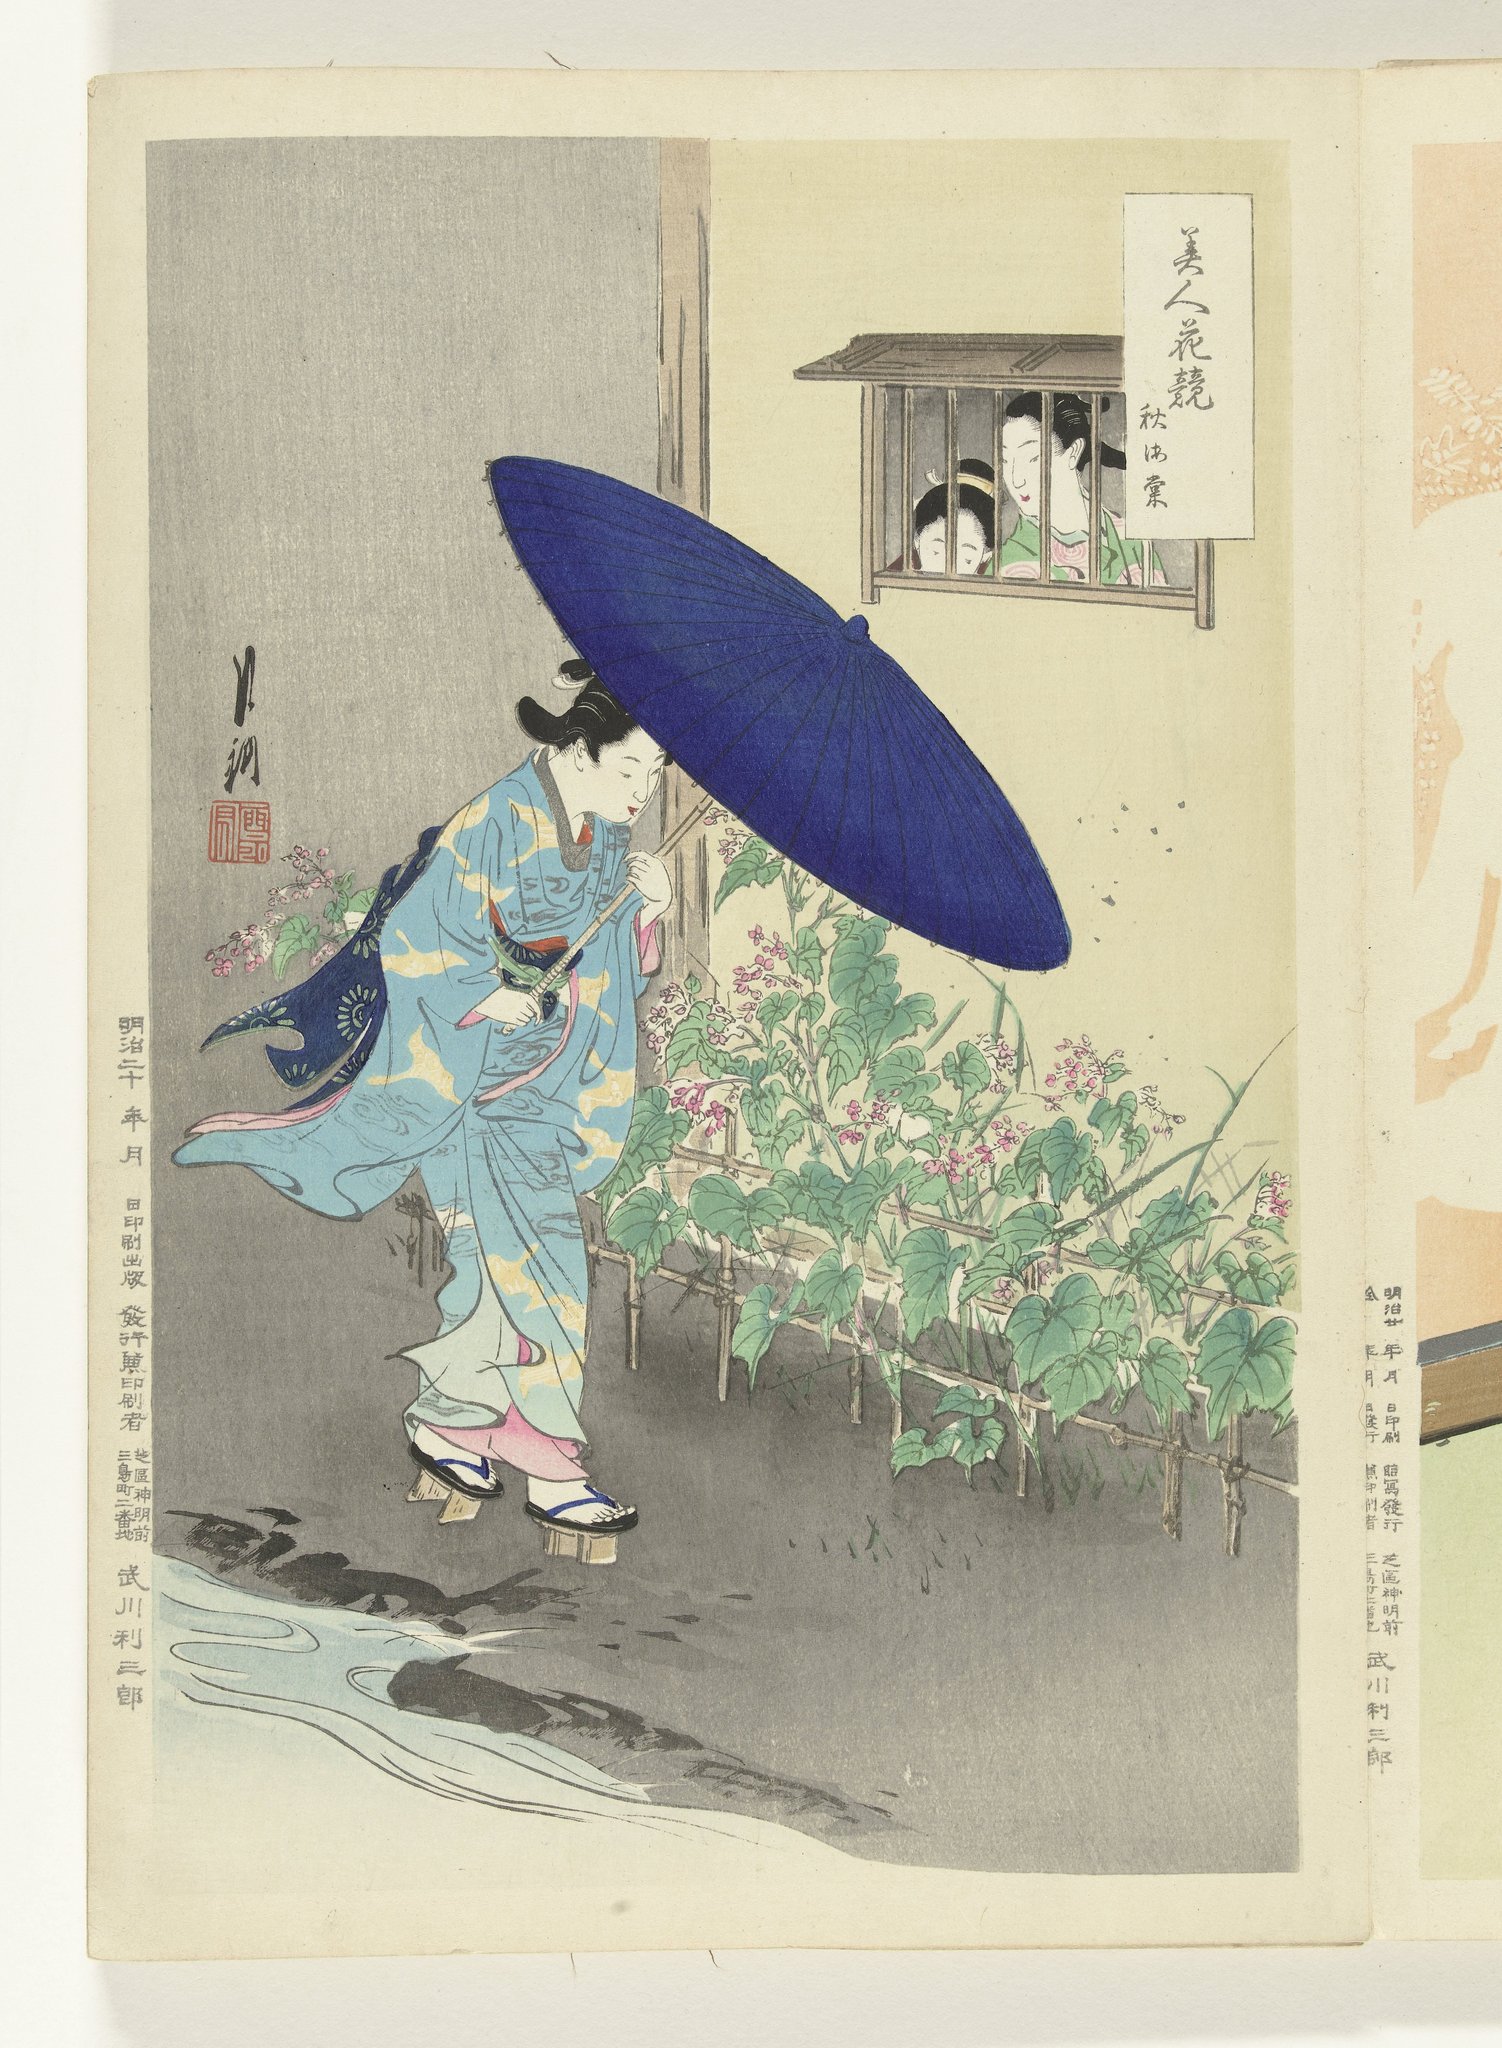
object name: print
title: Vergelijkingen tussen schoonheden en bloemen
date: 1887-1896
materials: paper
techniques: blind stamped, woodcut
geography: japan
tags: housing, umbrella, walking - aa - female human figure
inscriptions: collector's mark: Lugt 2760, collector's mark: Lugt 2228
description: Vrouw met blauwe parasol, lopend tussen water en bloeiende heg; twee vrouwen toekijkend vanachter raam.